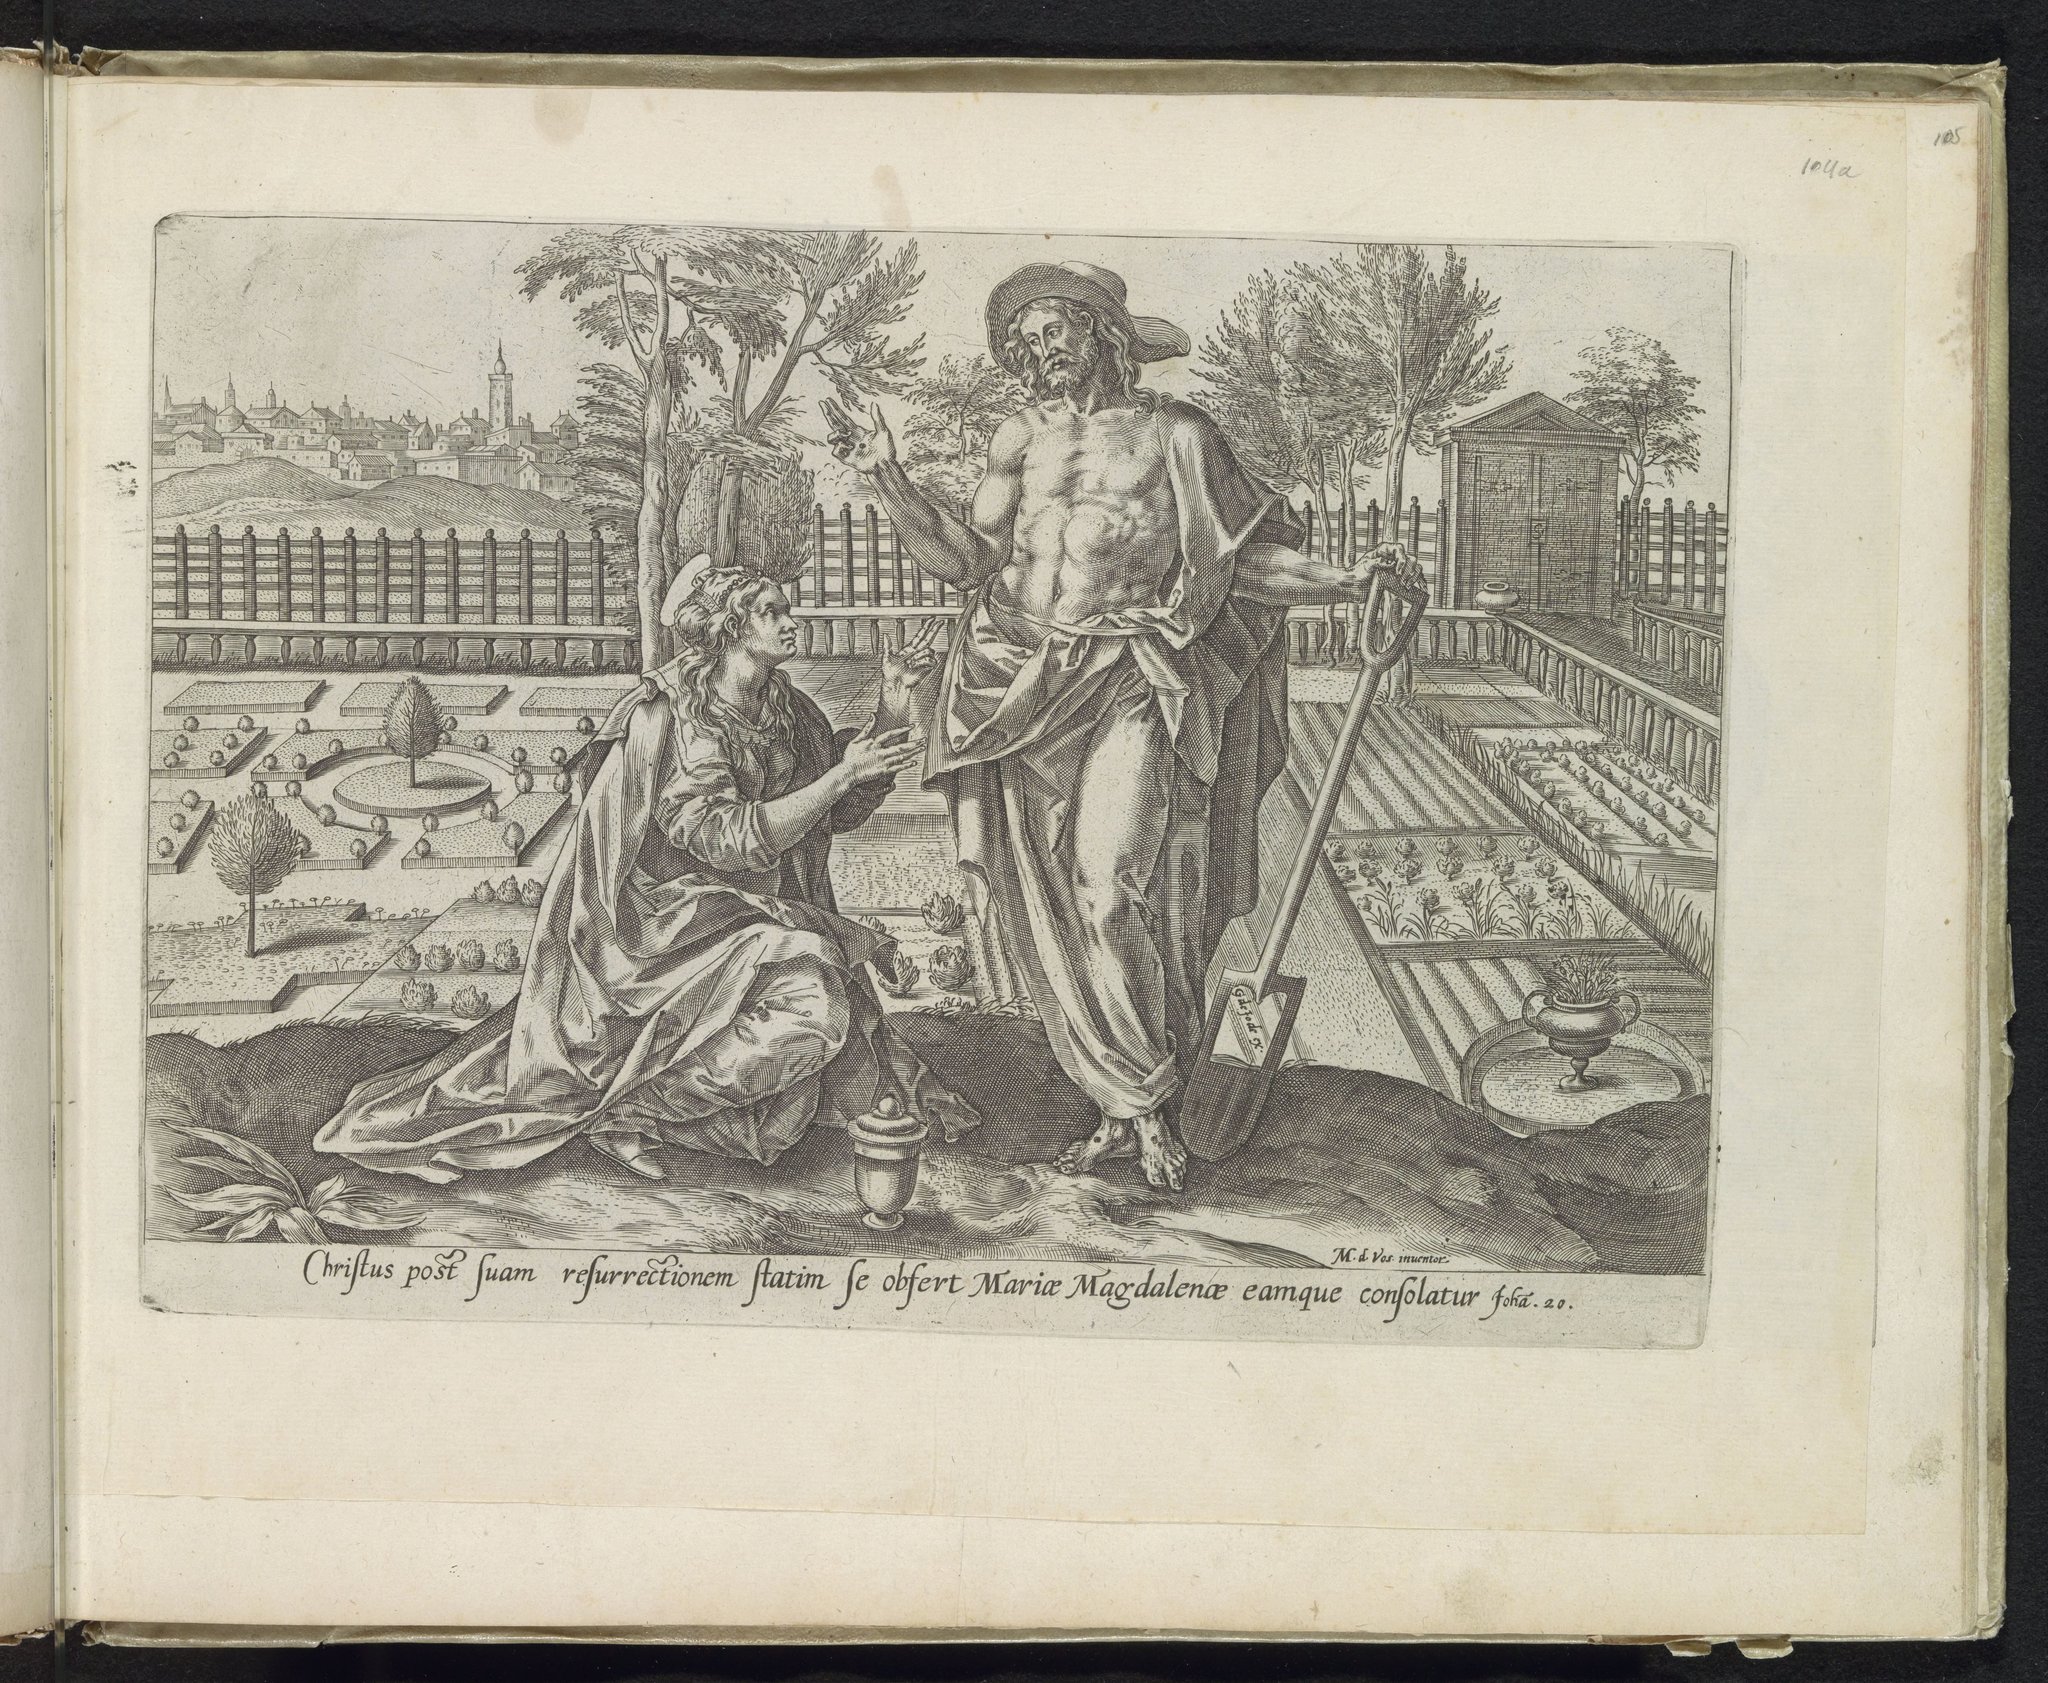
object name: album leaf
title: Christus verschijnt als tuinman aan Maria Magdalena (Noli me tangere)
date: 1585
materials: paper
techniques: engraving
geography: antwerp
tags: mary magdalene kneeling before christ, who is usually represented as a gardener with a hoe and/or a spade; 'noli me tangere'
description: Maria Magdalena herkent de opgestane Christus, nadat ze hem voor tuinman had aangezien, en knielt voor hem. Christus is gekleed als tuinman. Hij zegt haar hem niet vast te houden. Onder de voorstelling een verwijzing in het Latijn naar de Bijbeltekst in Joh. 20. Deze prent maakt deel uit van een album.